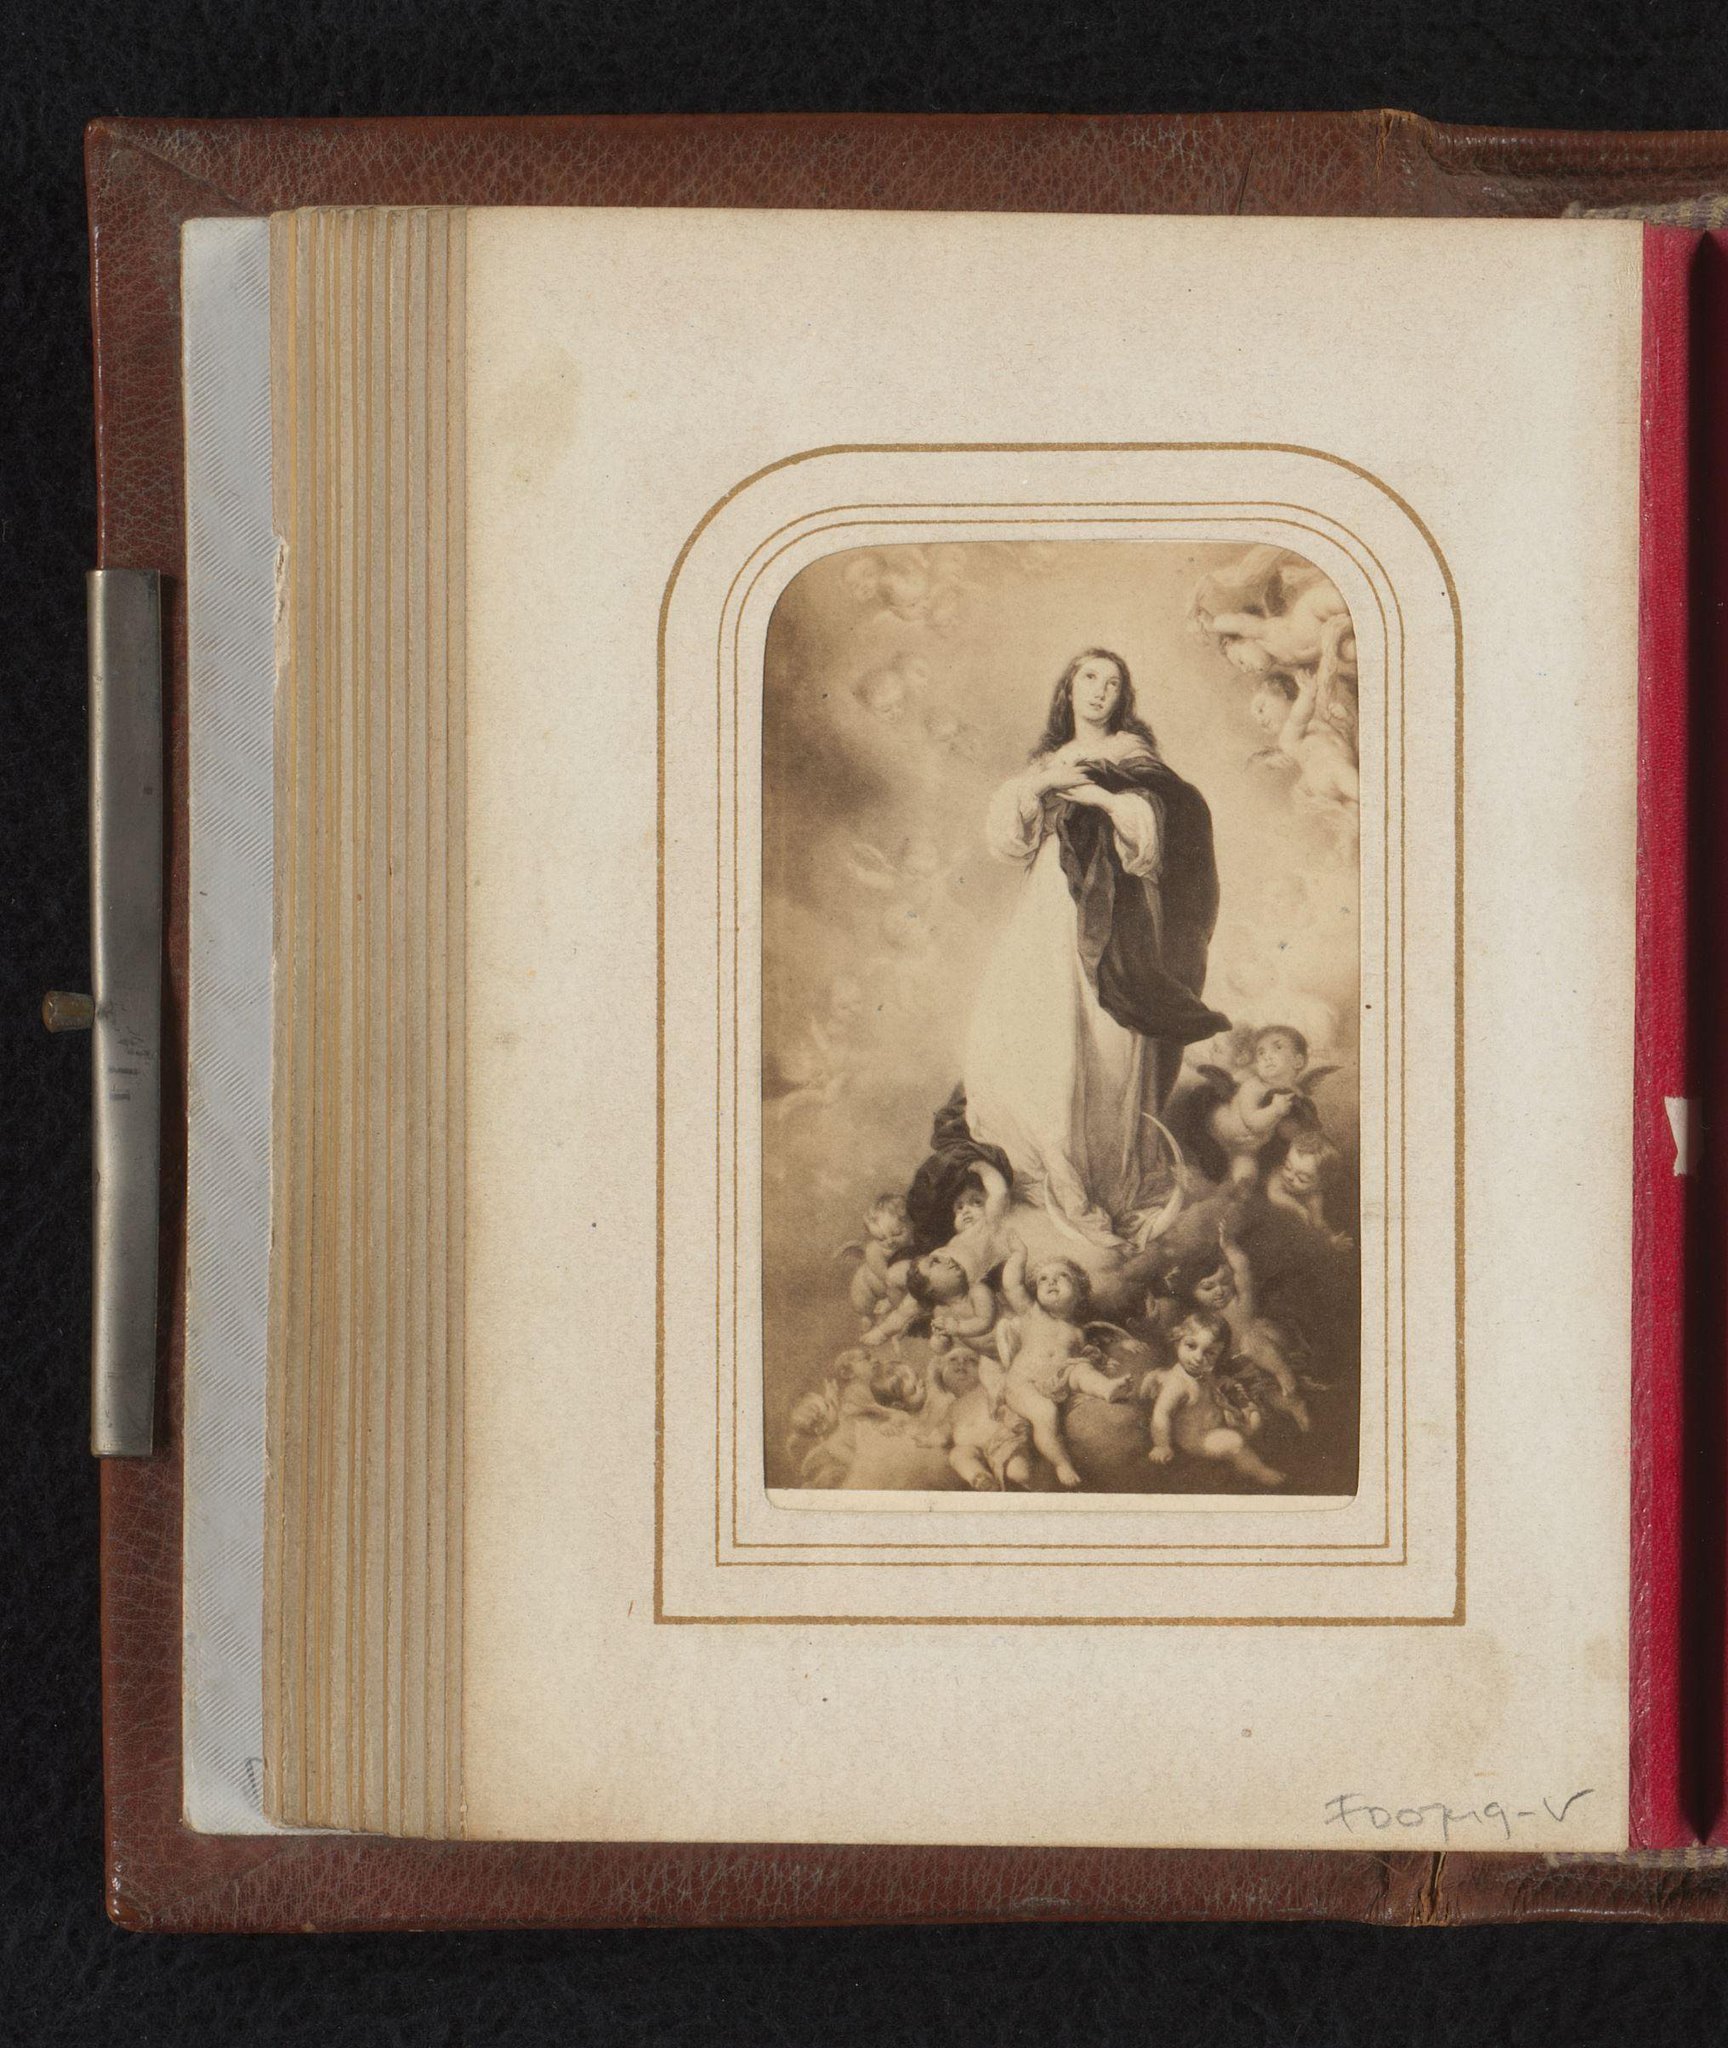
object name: photograph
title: Fotoreproductie van The Immaculate Conception of Los Venerables door Bartolomé Esteban Murillo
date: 1865-1900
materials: cardboard, photographic support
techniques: albumen print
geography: berlin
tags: madonna (i.e. mary with the christ-child) in the air, or on the clouds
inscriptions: inscription: ‘Murillo: Immaculée conception/ 117/ Gustav Schauer/ Photographisches Kunst- und Verlags - Institut/ Berlin/ Grosse Friedrichs - Strasse 188’